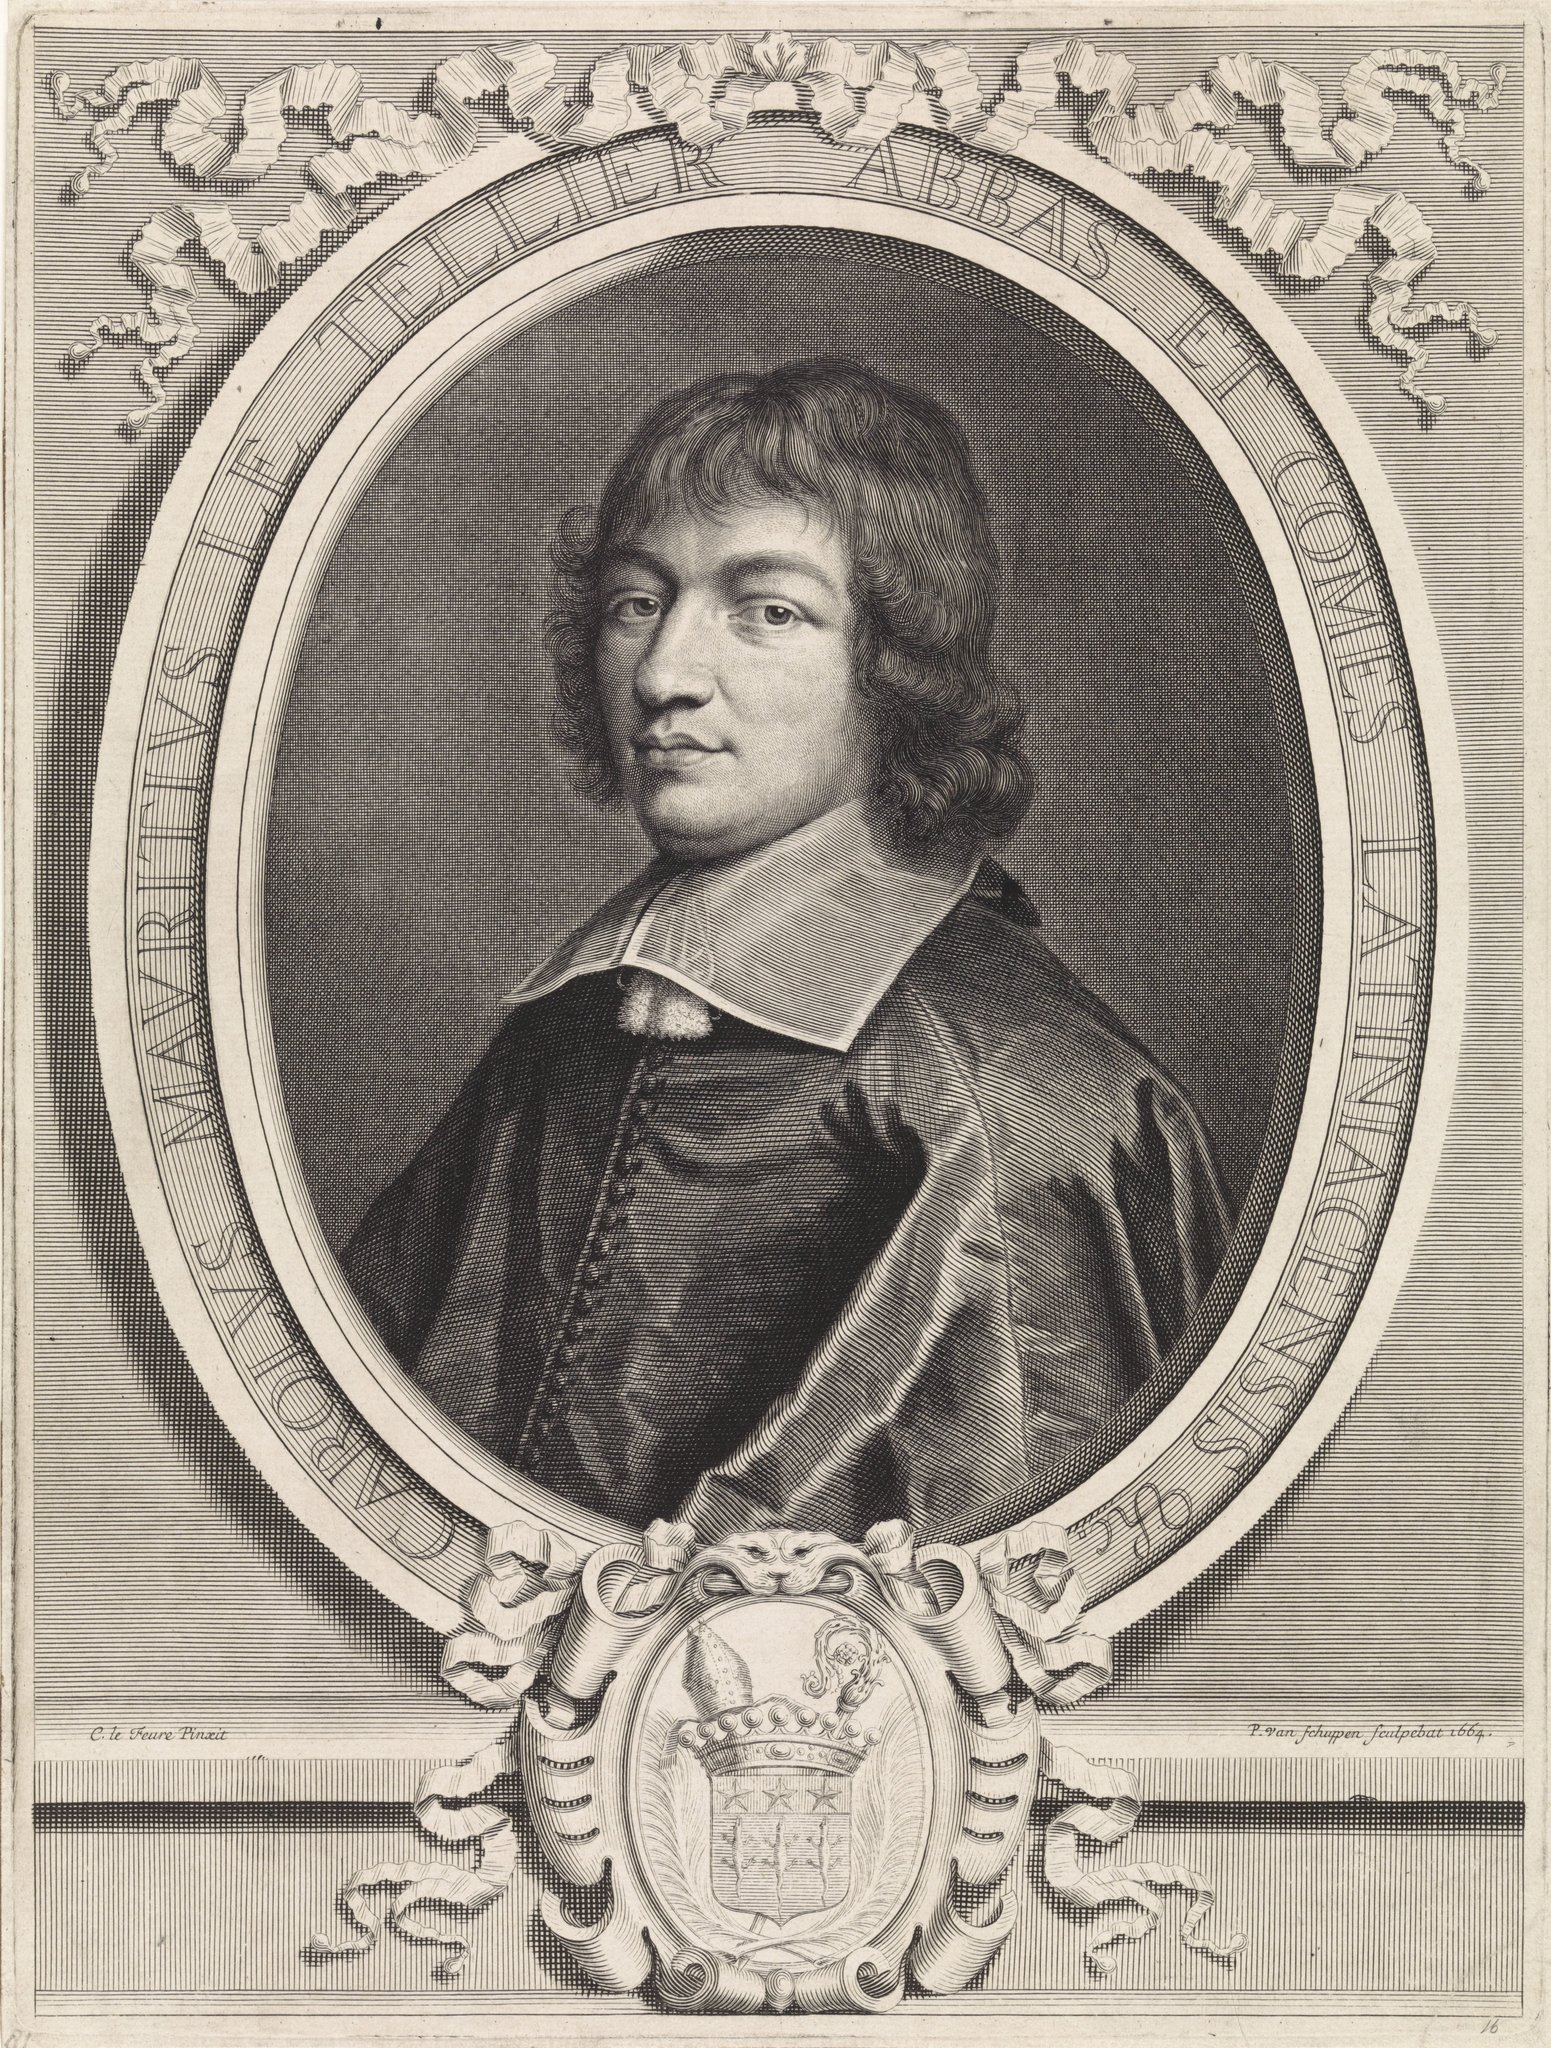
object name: print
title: Portret van Charles-Maurice le Tellier, abt van Lagny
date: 1607-1664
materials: paper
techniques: engraving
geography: paris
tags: priest, charles-maurice le tellier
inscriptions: collector's mark: Lugt 240